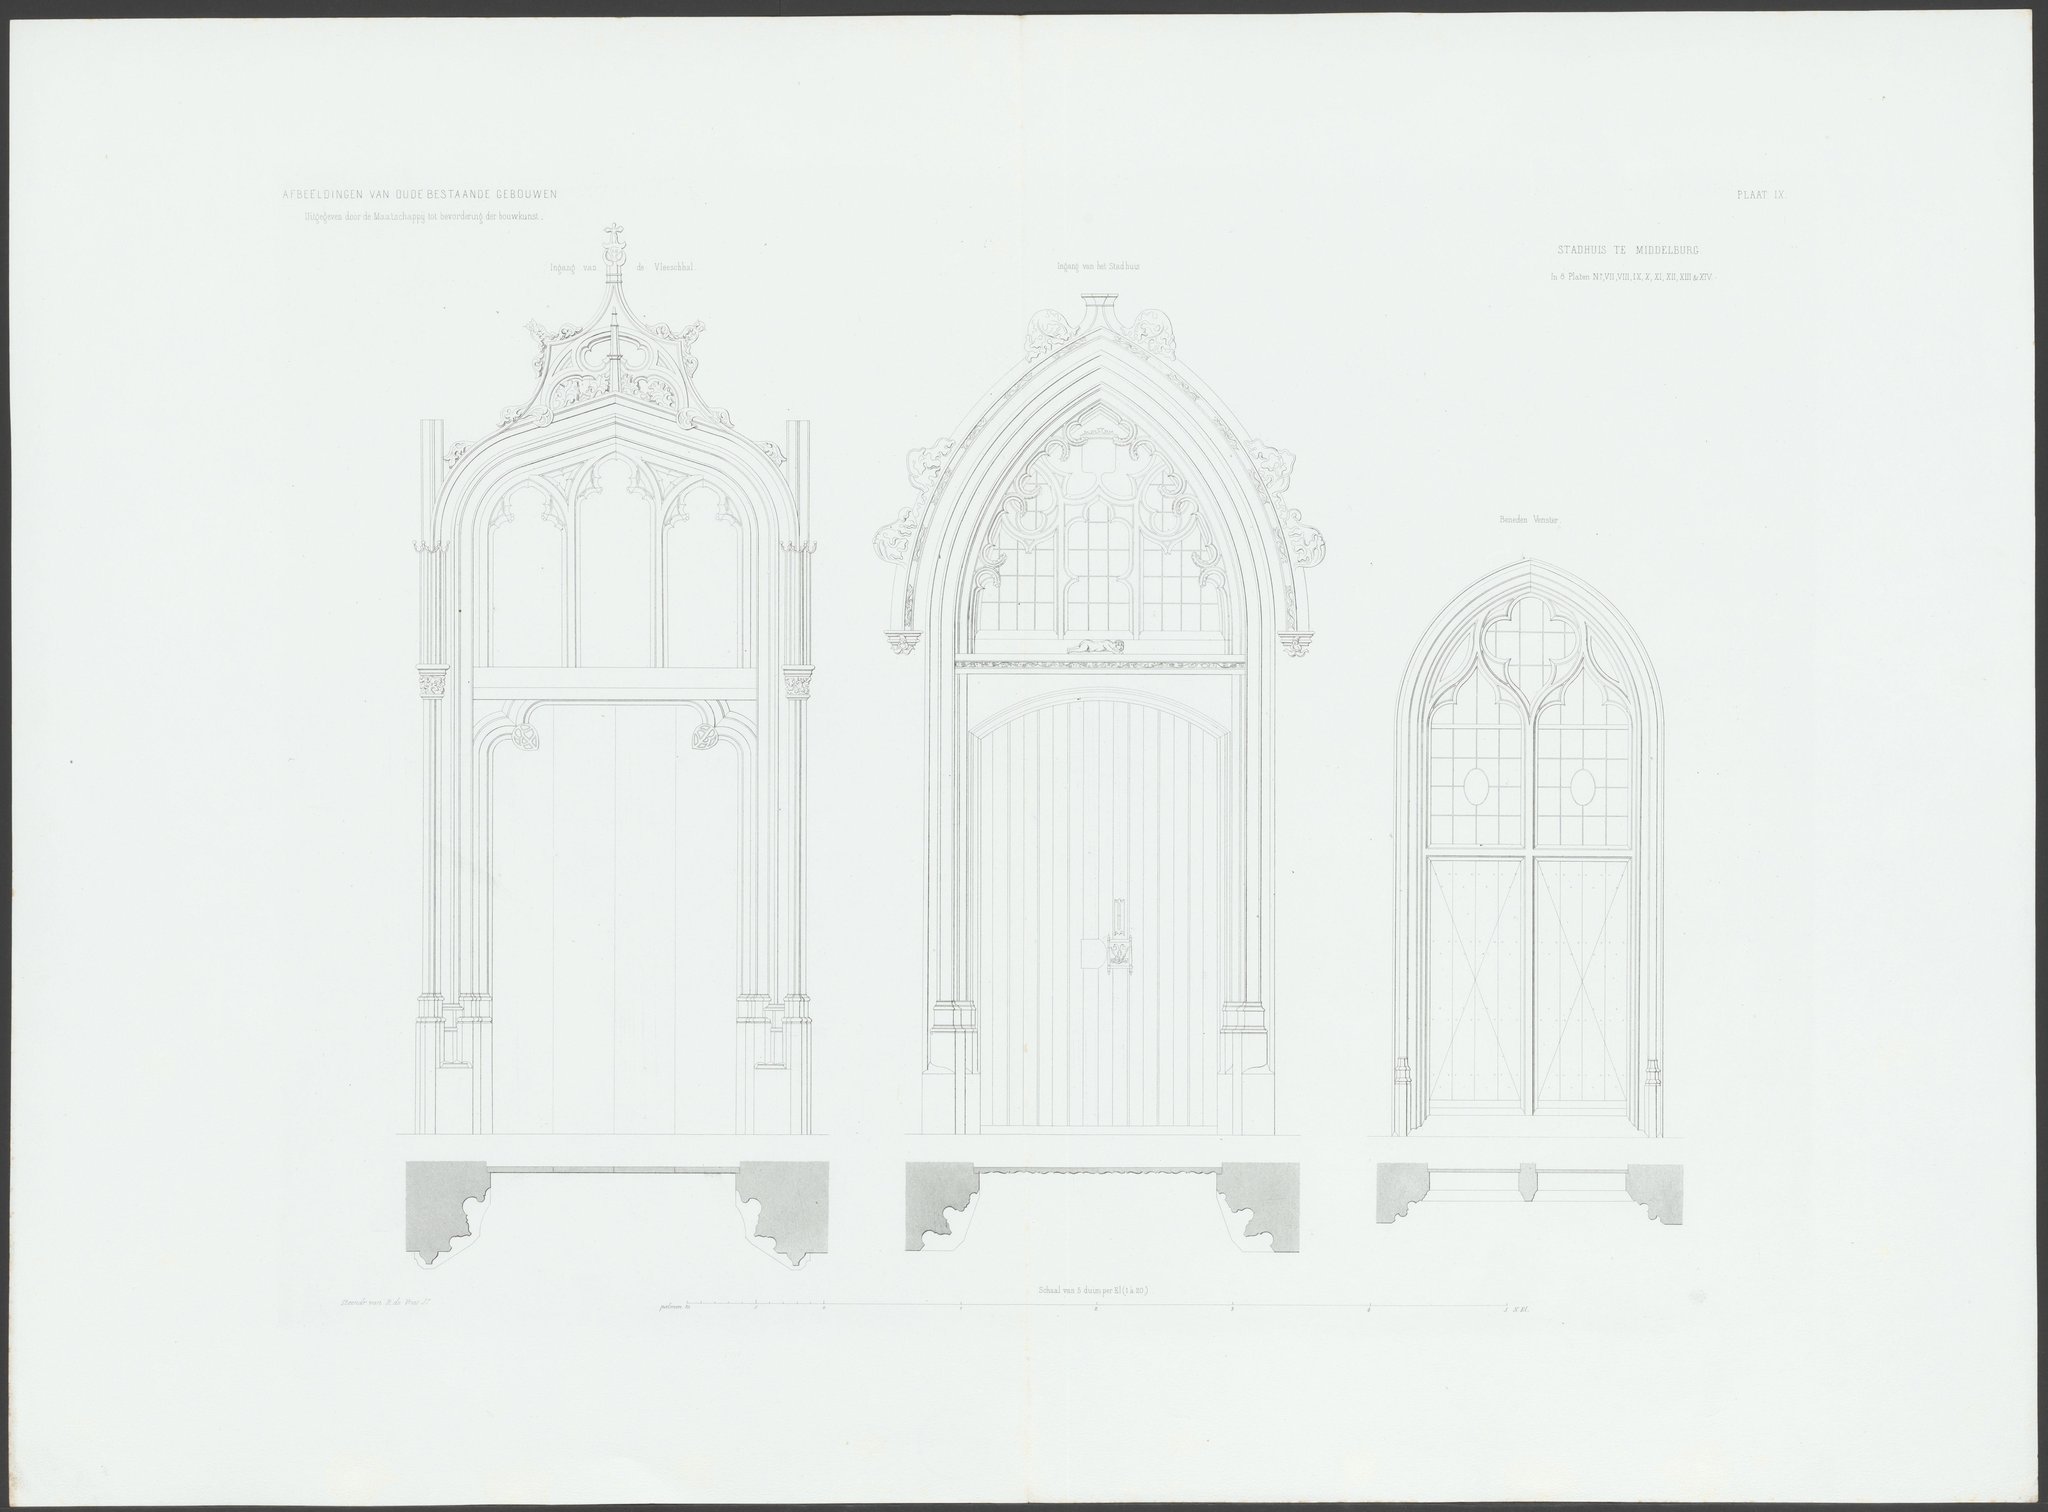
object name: print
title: Stadhuis te Middelburg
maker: ruurt de vries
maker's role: print maker, printer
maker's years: 1813-1874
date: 1854-1907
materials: paper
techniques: lithograph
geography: netherlands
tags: architectural detail, townhall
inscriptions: collector's mark: Lugt 1641, collector's mark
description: Twee ingangen en een venster in het stadhuis van Middelburg. Onderaan een schaalstok. Dubbelgevouwen blad. Architectuurvoorstelling. Plaat XIV. Onderwerpsrubrieken binnen de Atlas Zeden en Gewoonten: Regeering, Stadhuizen (H-M).